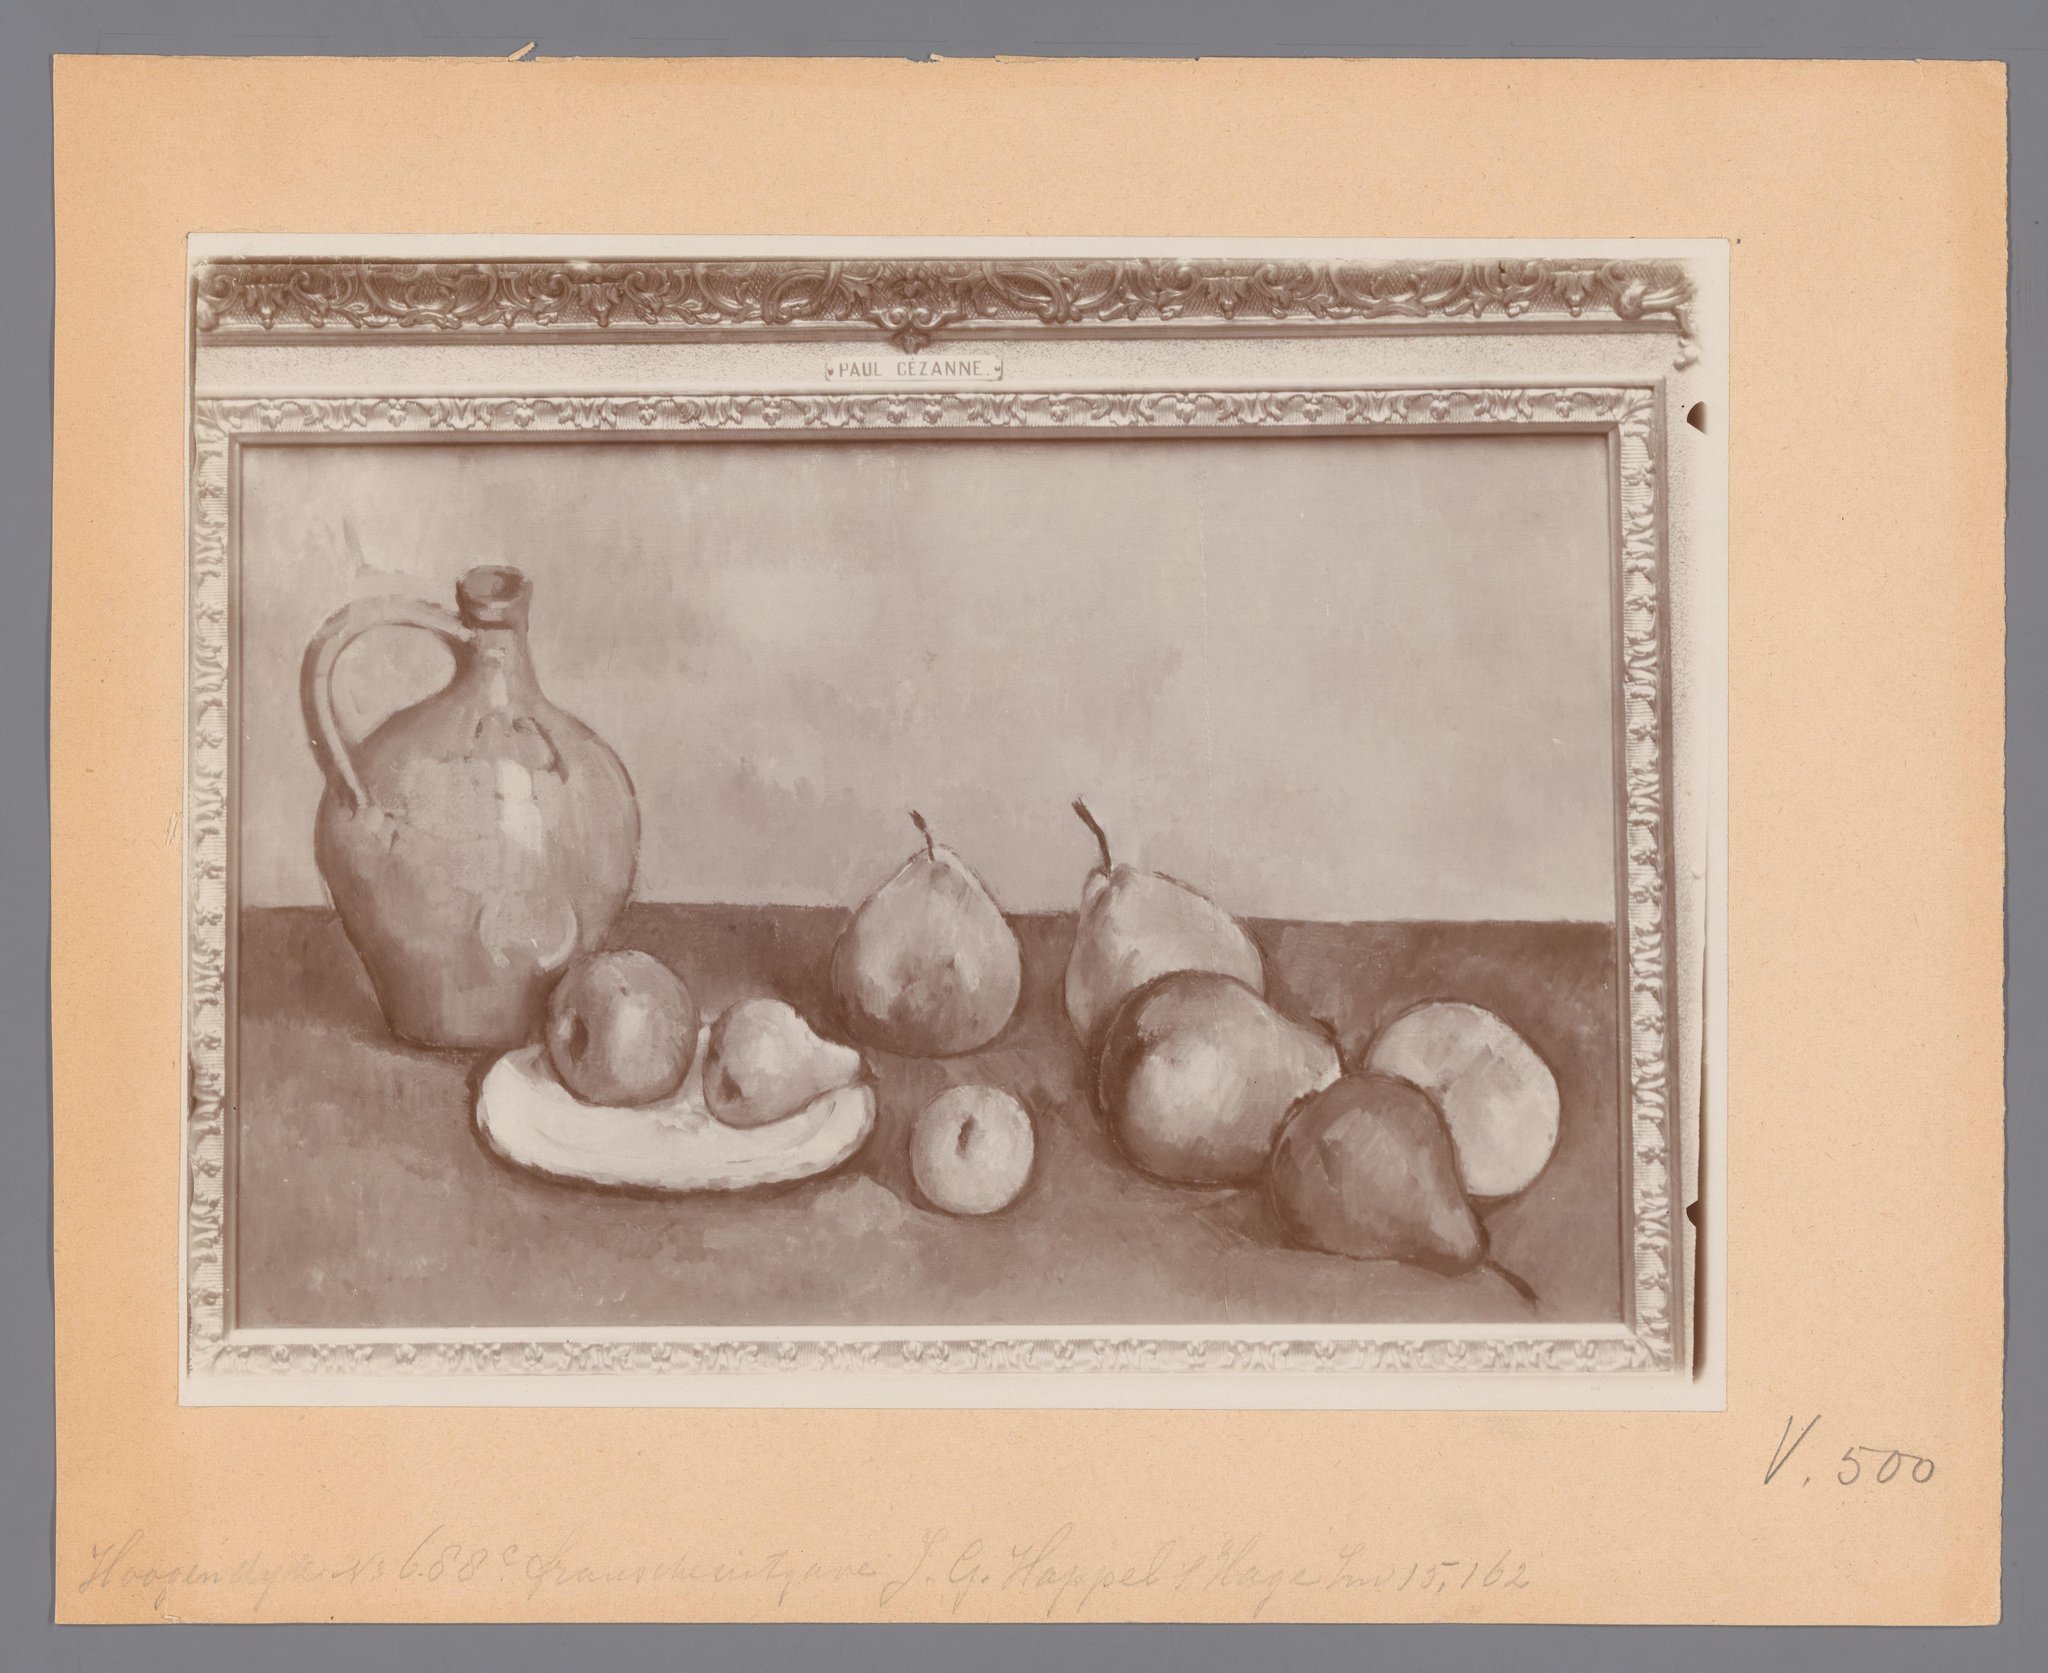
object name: photograph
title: Fotoreproductie van een schilderij met fruitstilleven door Paul Cézanne uit de collectie Hoogendijk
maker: johannes gerardus happel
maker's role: publisher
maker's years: 1854-1928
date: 1915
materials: paper, cardboard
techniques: gelatin silver print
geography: the hague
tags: still life of related objects, picture, painting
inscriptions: inscription: ‘Coll. Hoogendijk, J.G. Happel s'Hage Inv 15.163 688M’, collector's mark, inscription: ‘V. 623’, inscription: ‘15.163’